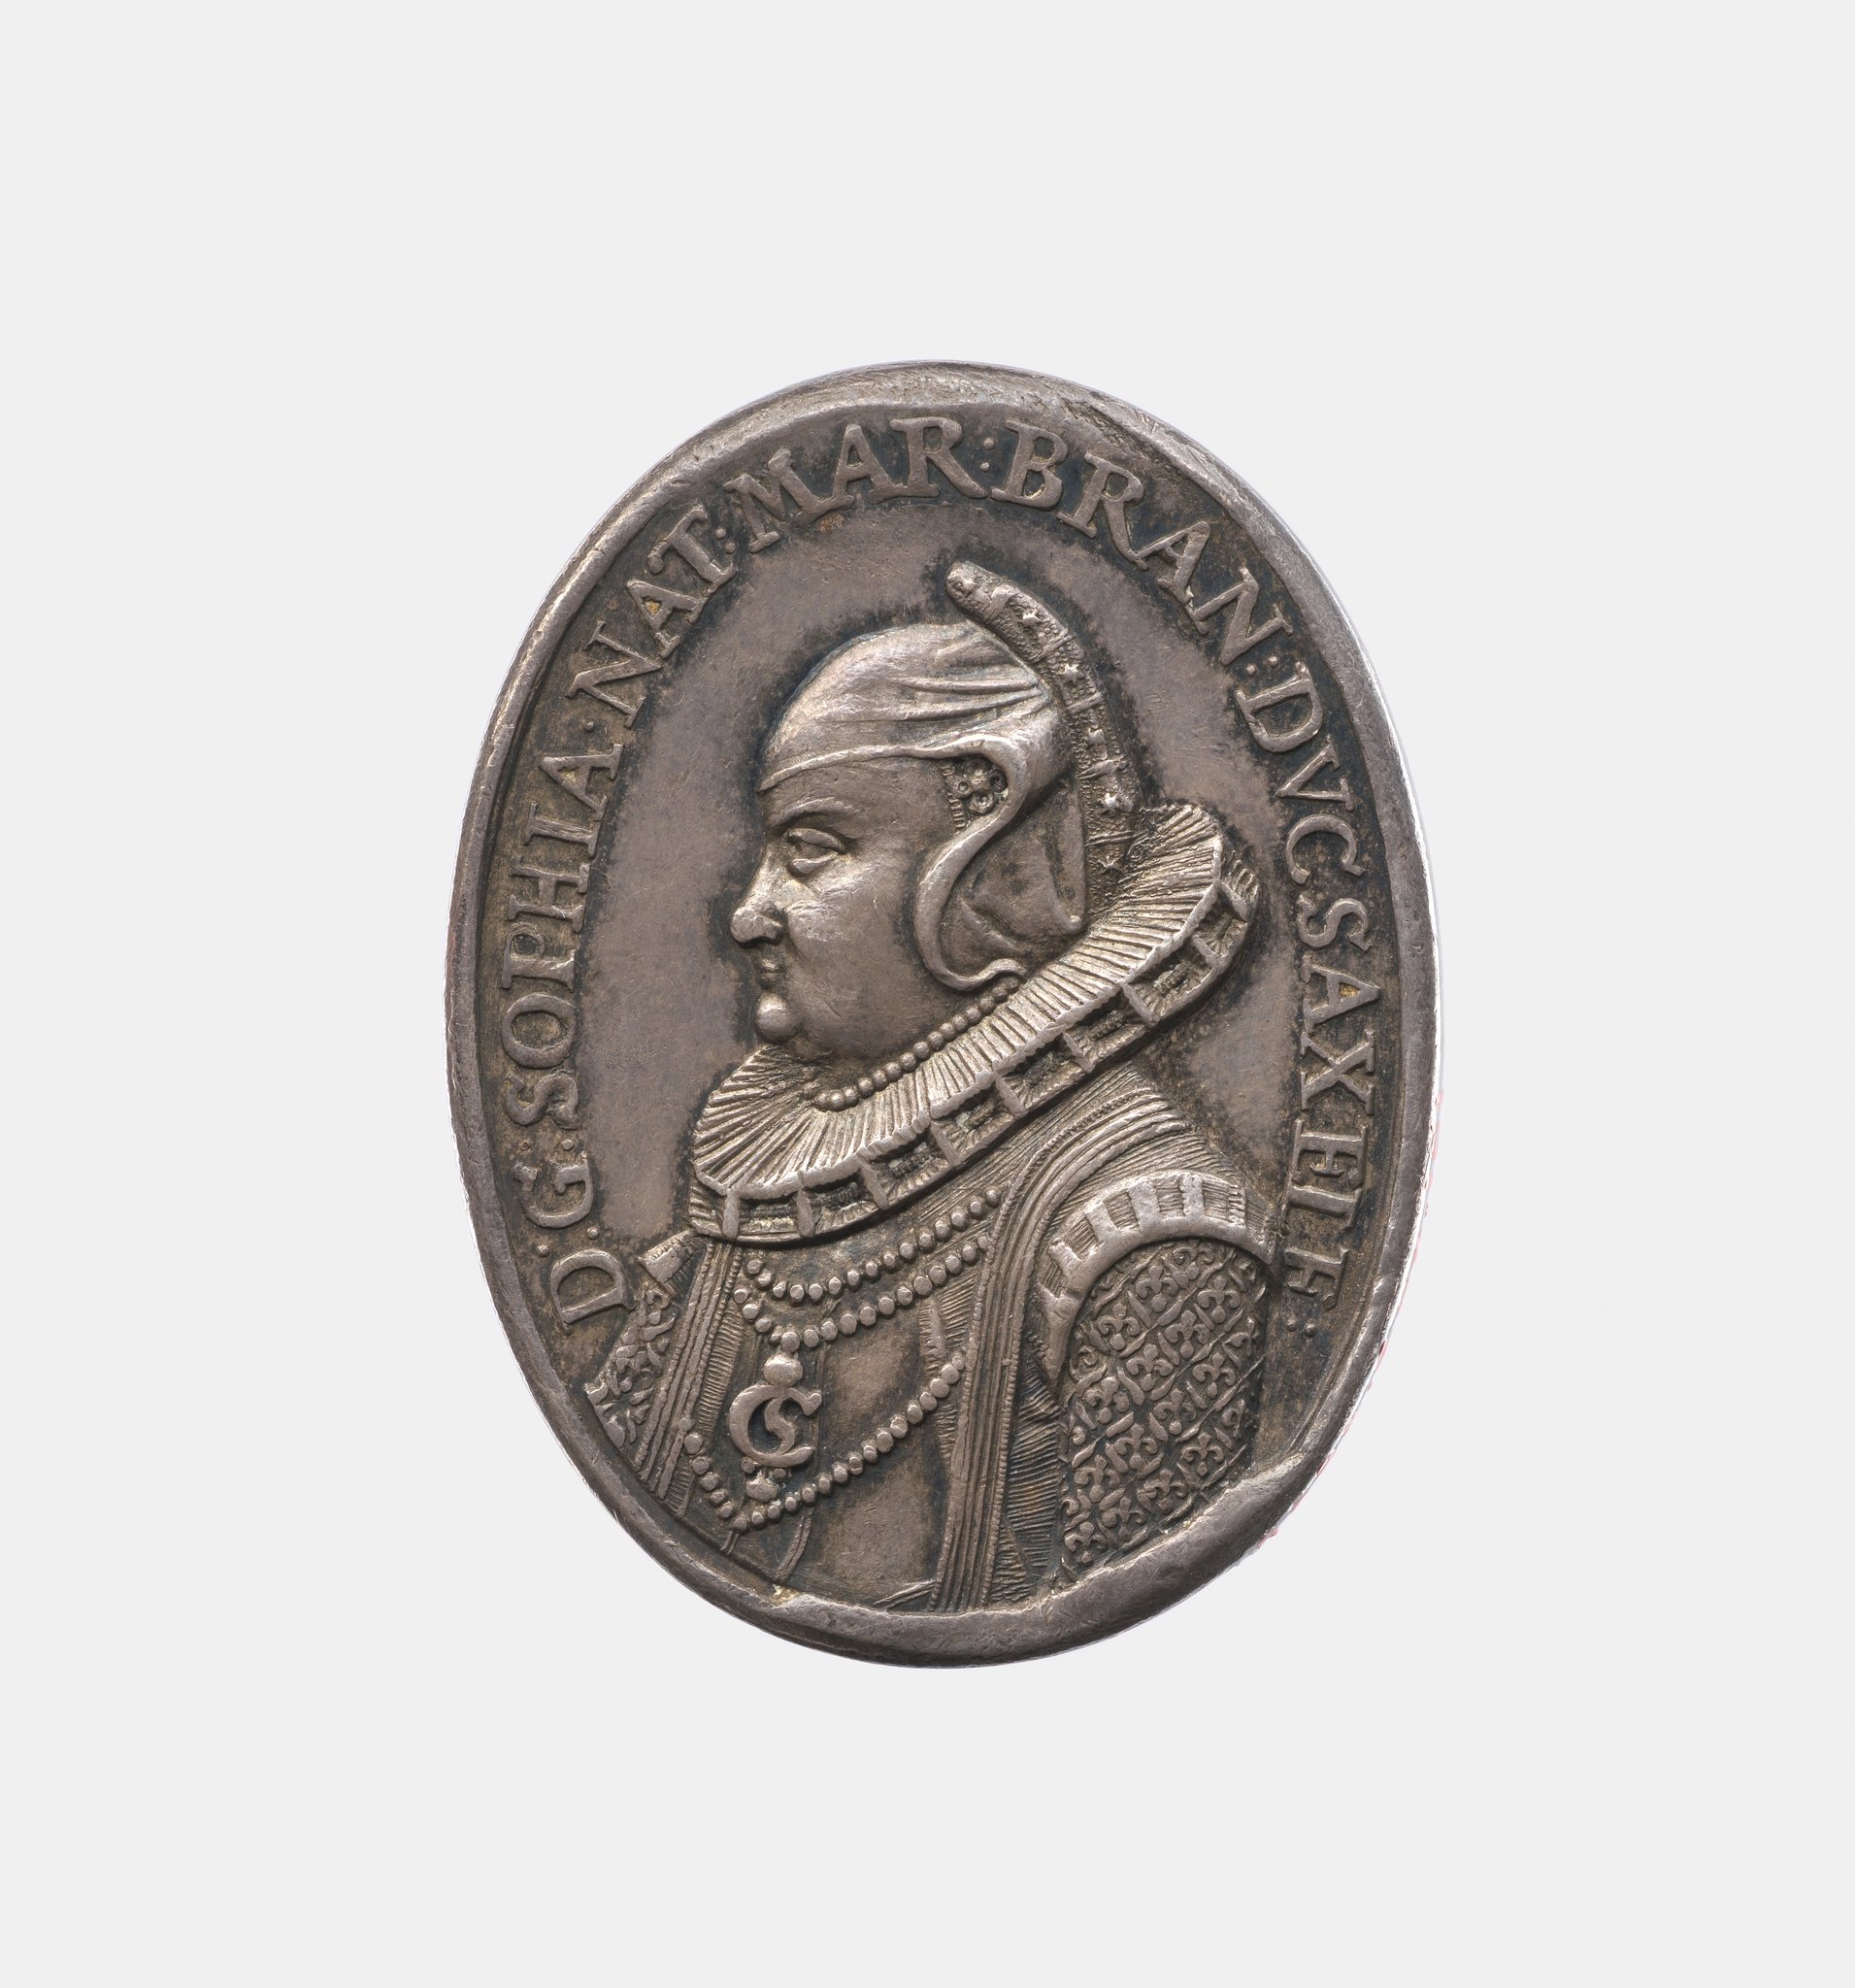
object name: medal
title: Sophia of Brandenburg 1568-1622, wife of Christian I, Elector of Saxony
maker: ruprecht niclas kitzkatz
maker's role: artist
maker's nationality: german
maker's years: 1615-1633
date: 1622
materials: silver